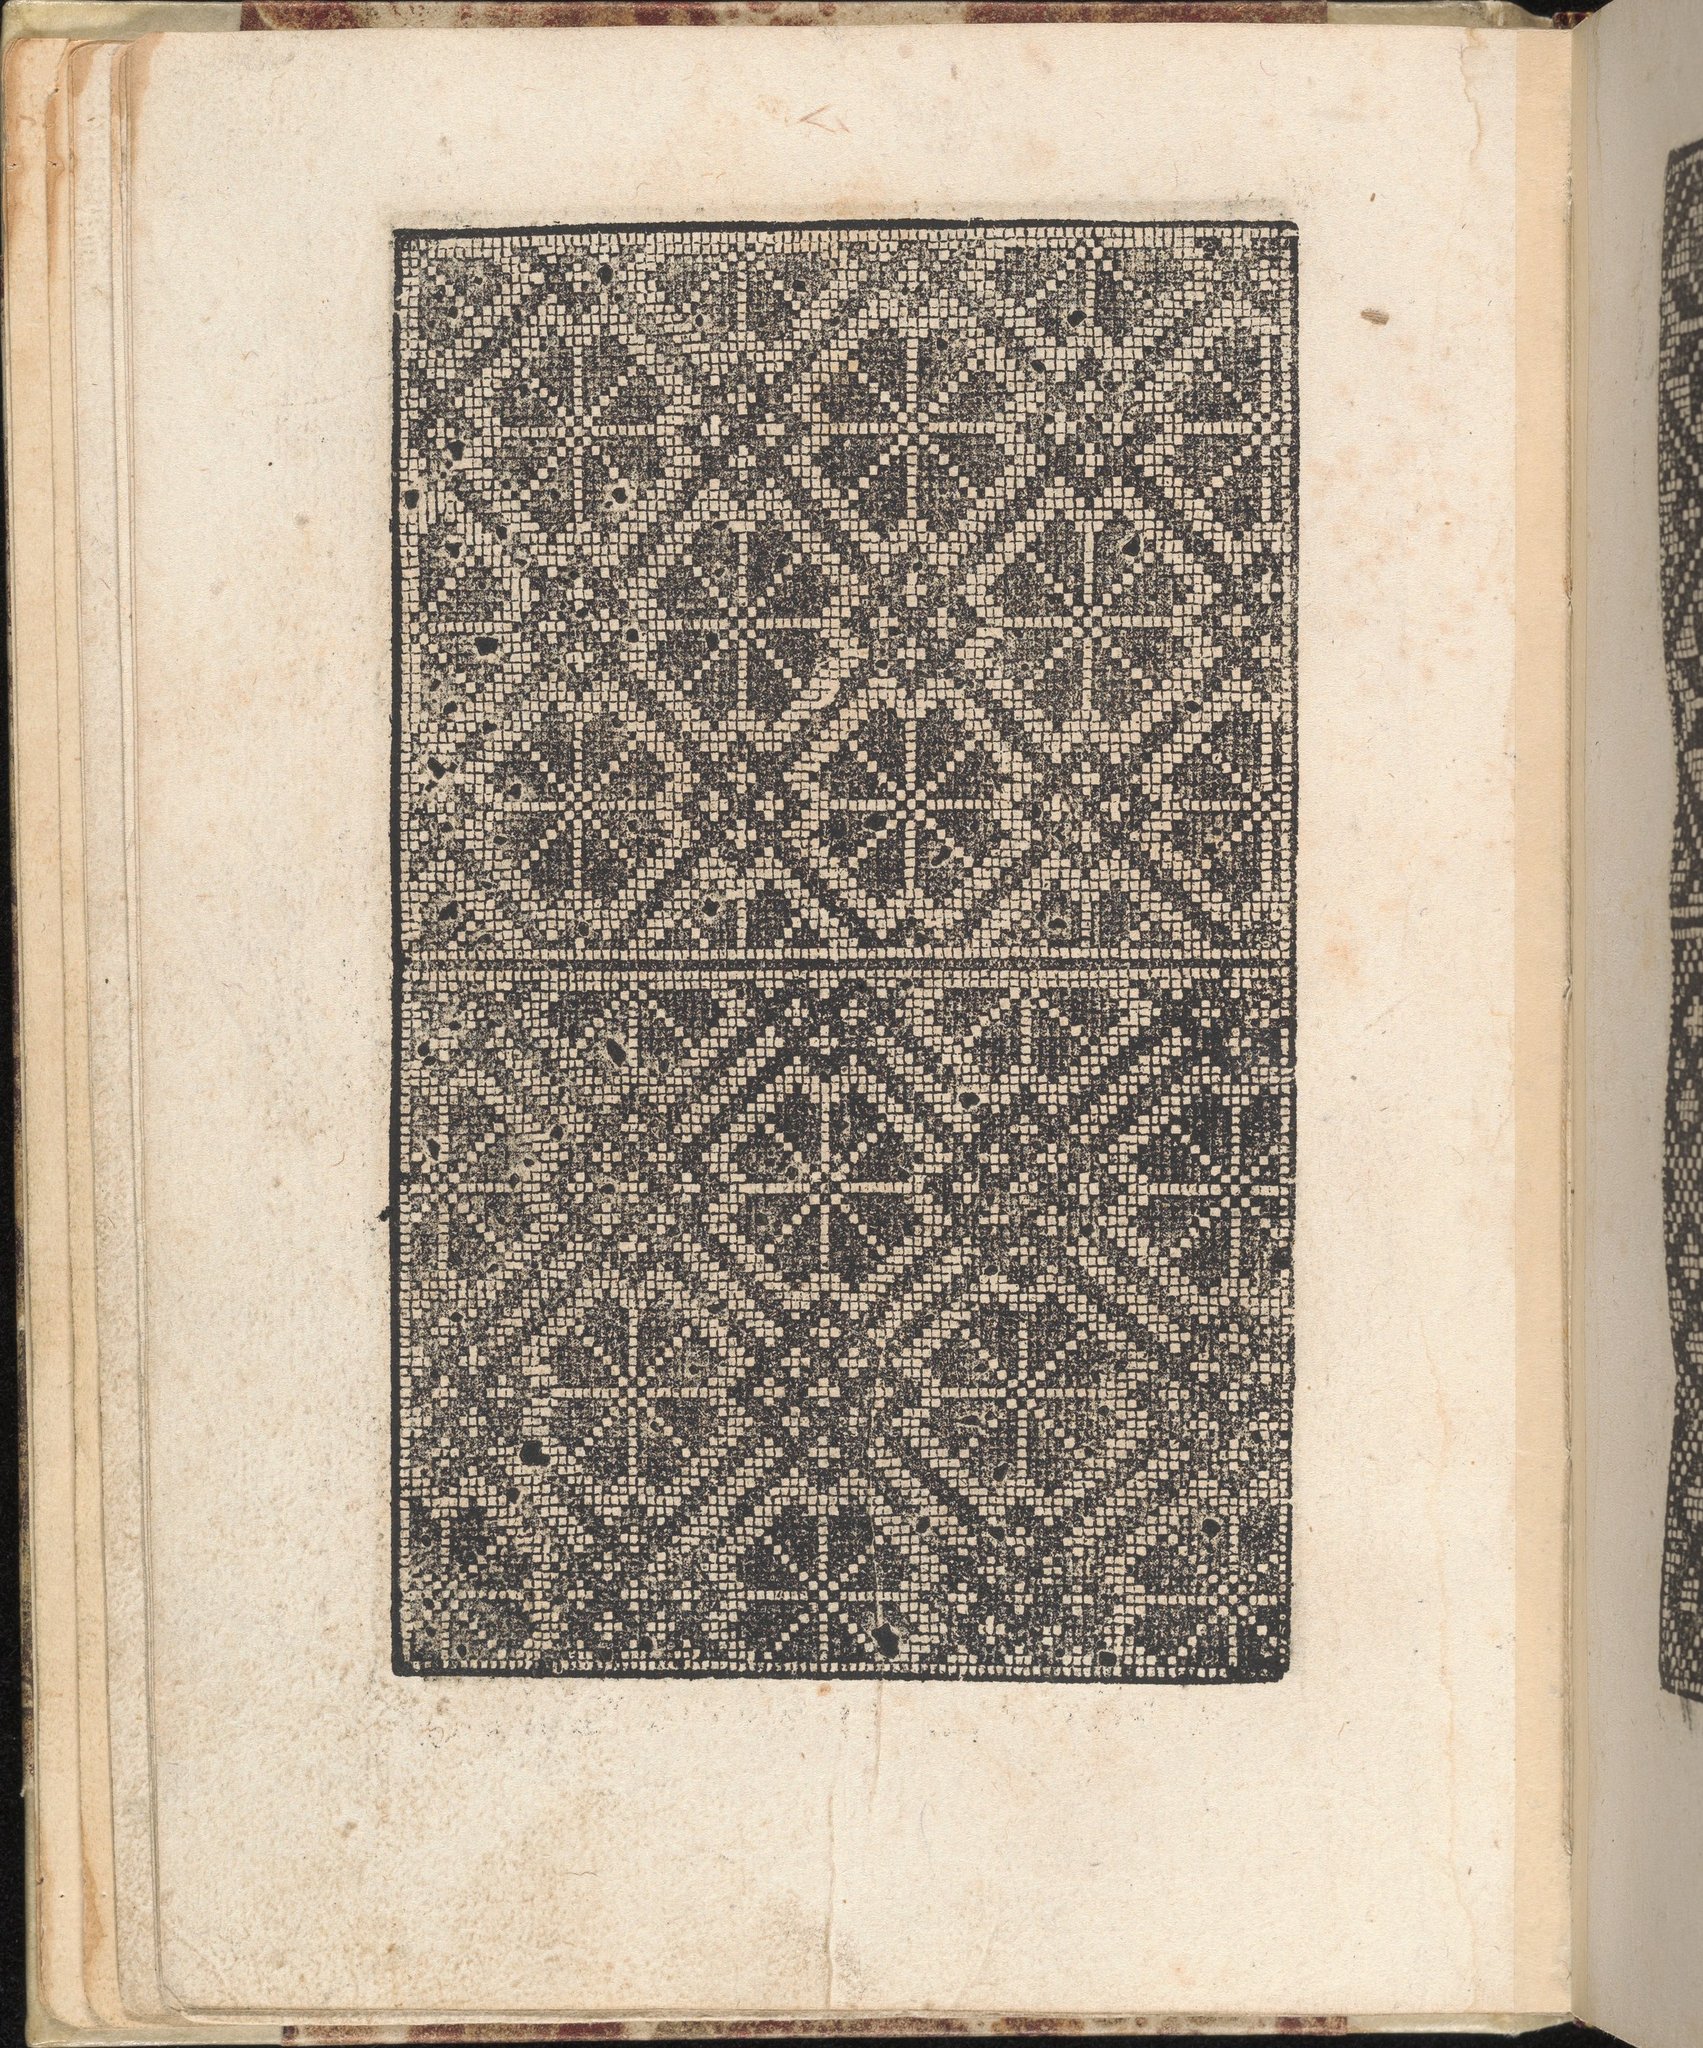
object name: book print ornament architecture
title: Ein new getruckt model Büchli...Page 11, recto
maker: johann schönsperger the younger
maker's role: publisher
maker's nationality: german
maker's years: 1490-1550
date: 1529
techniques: woodcut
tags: ornament